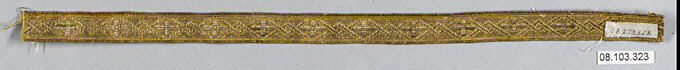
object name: galloon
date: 1801-1900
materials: metal thread, silk